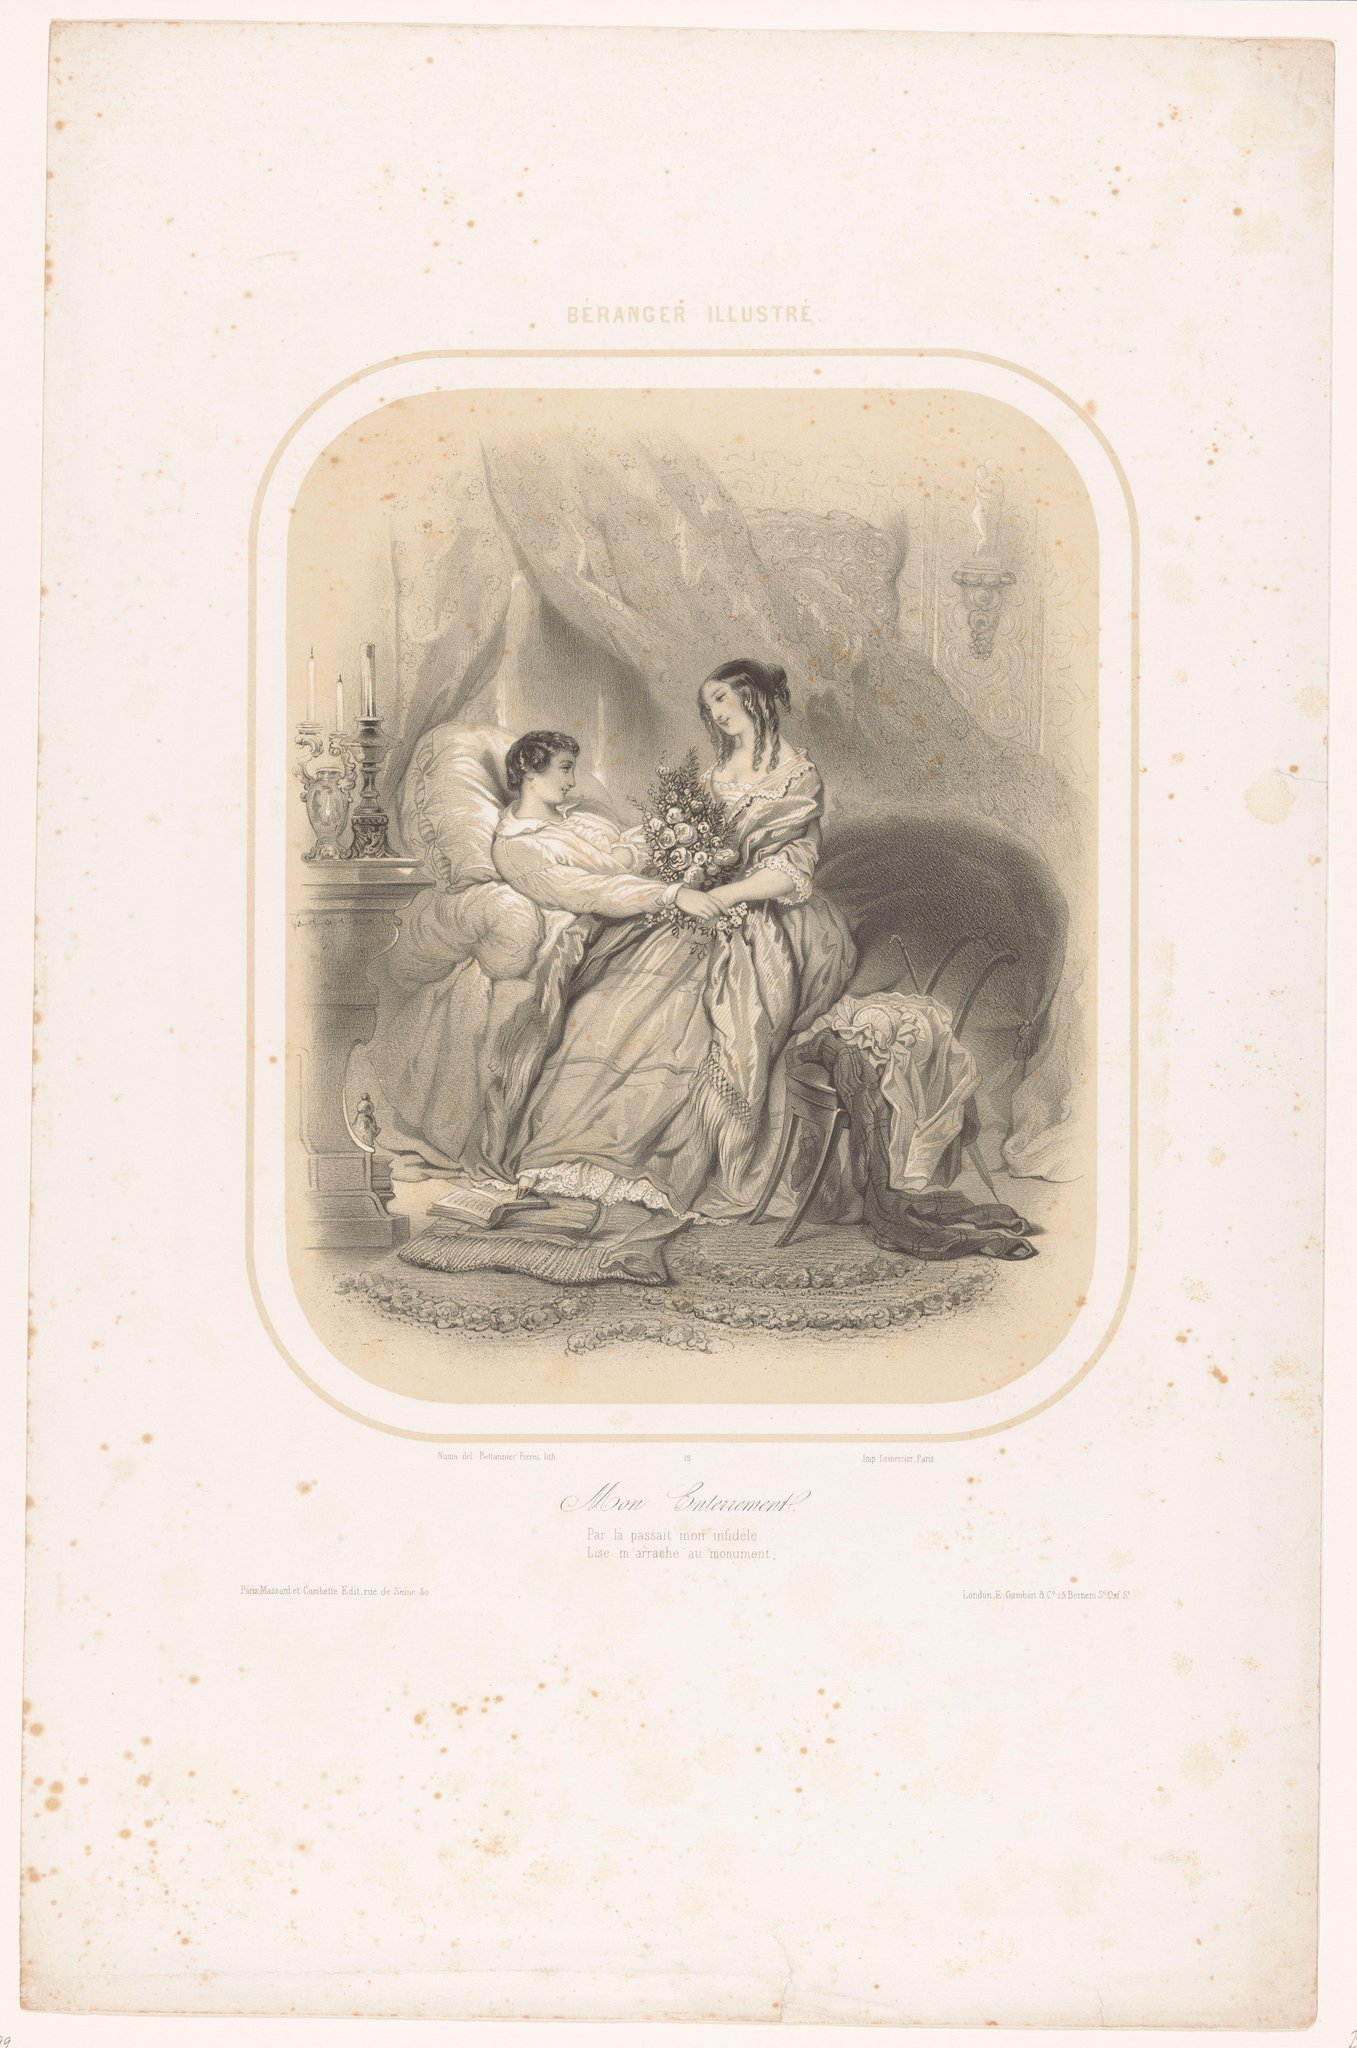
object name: print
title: Béranger illustré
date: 1851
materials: paper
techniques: tone lithography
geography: london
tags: deathbed, parting, leave-taking (of lovers)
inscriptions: collector's mark: Lugt 2228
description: De prent is een illustratie bij het gedicht 'Mon Enterrement' van Pierre-Jean de Béranger.